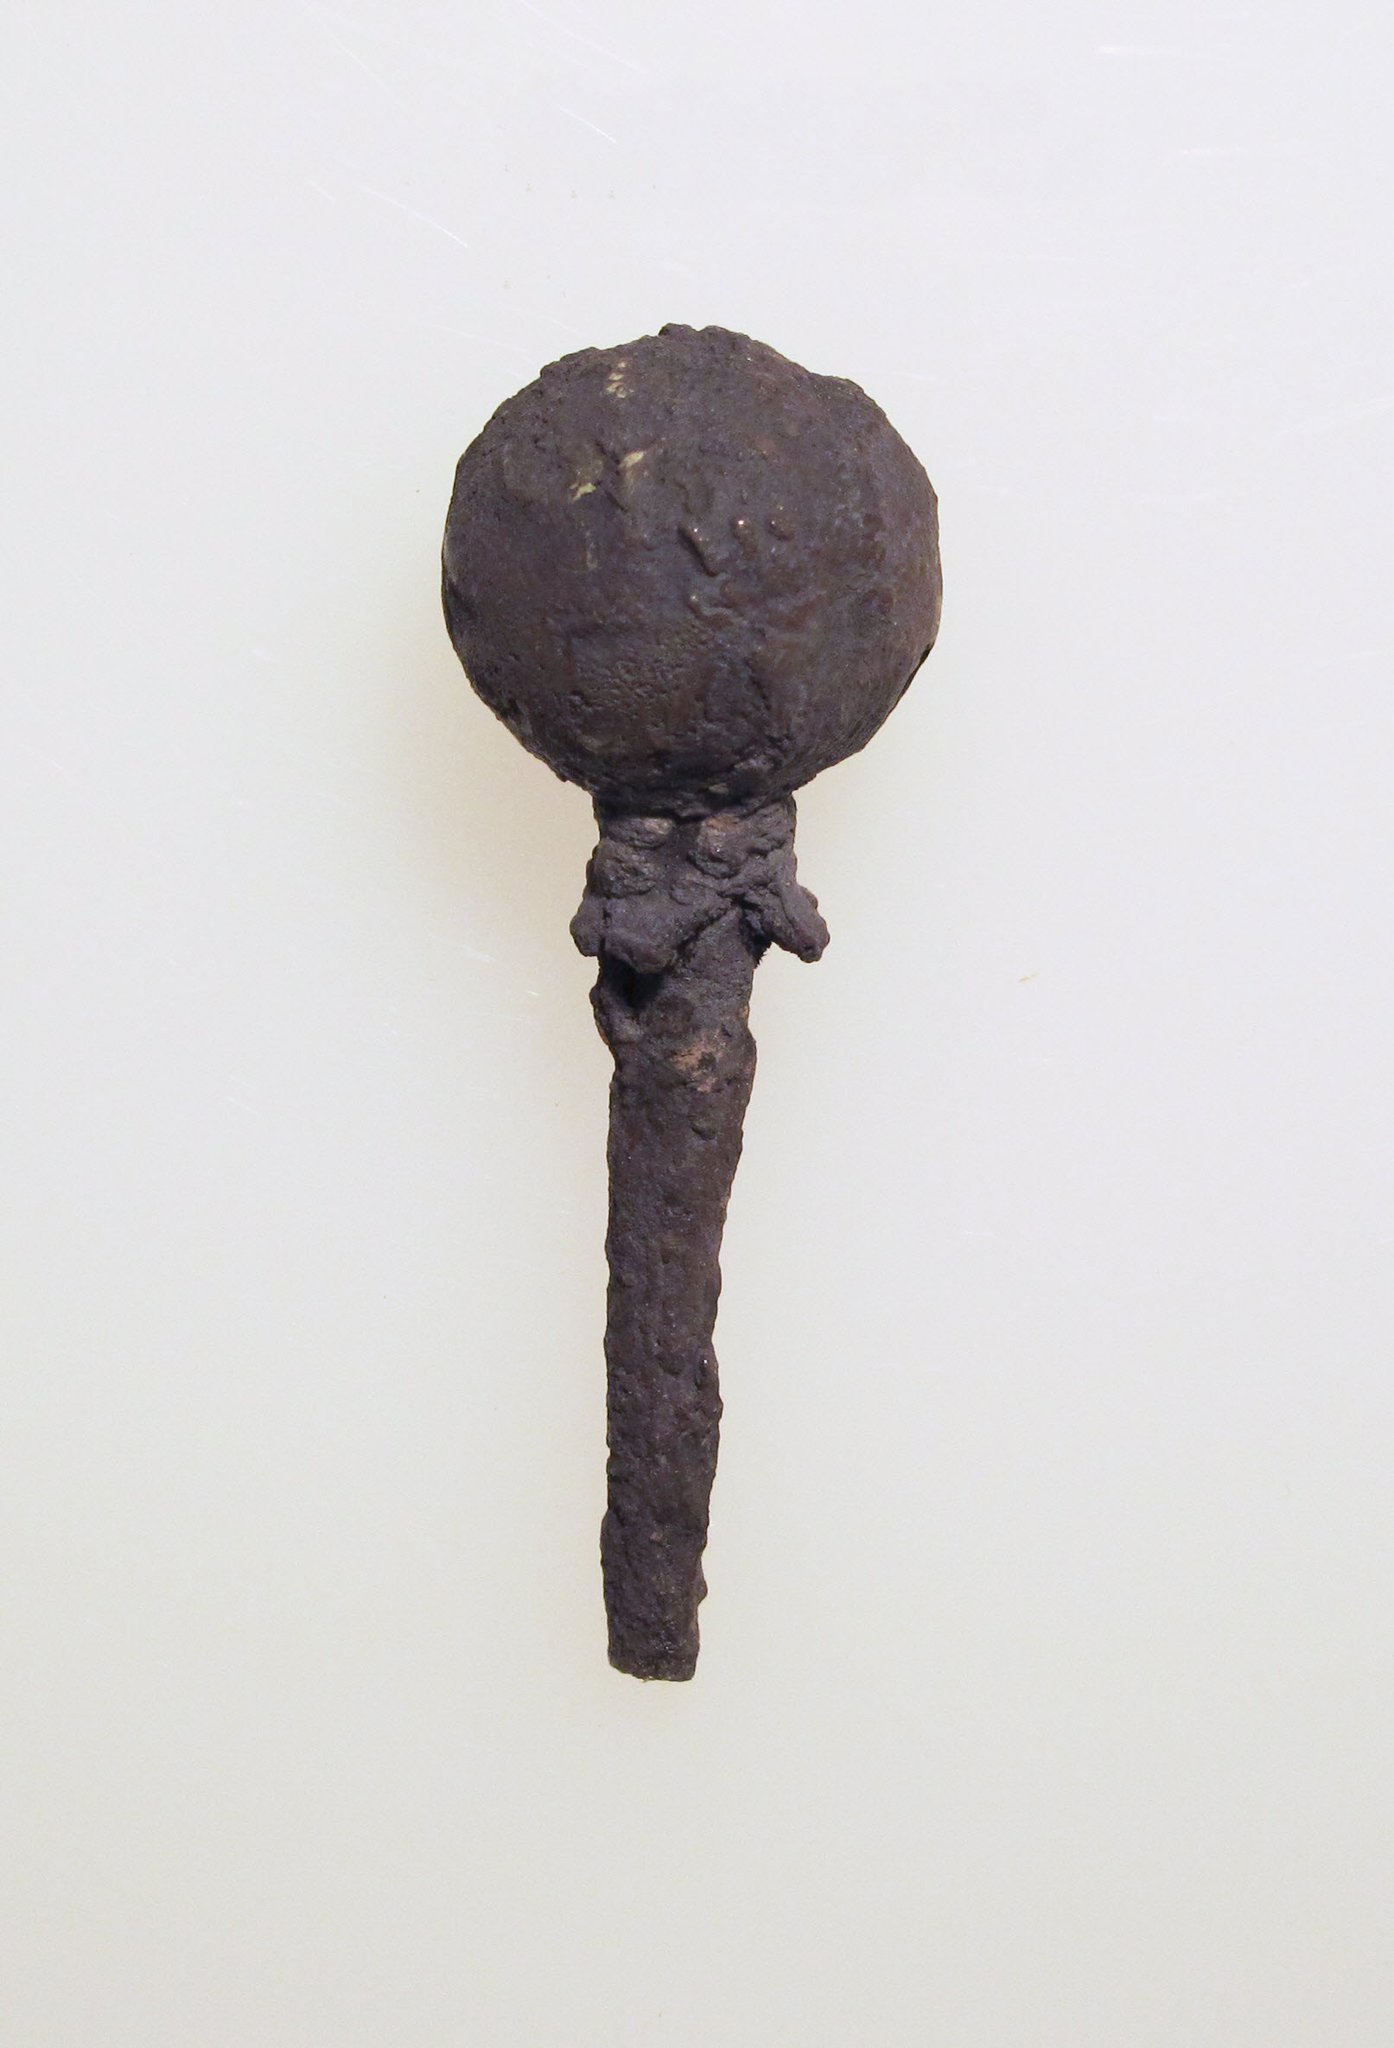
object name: pin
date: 7000 BCE-330 CE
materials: silver